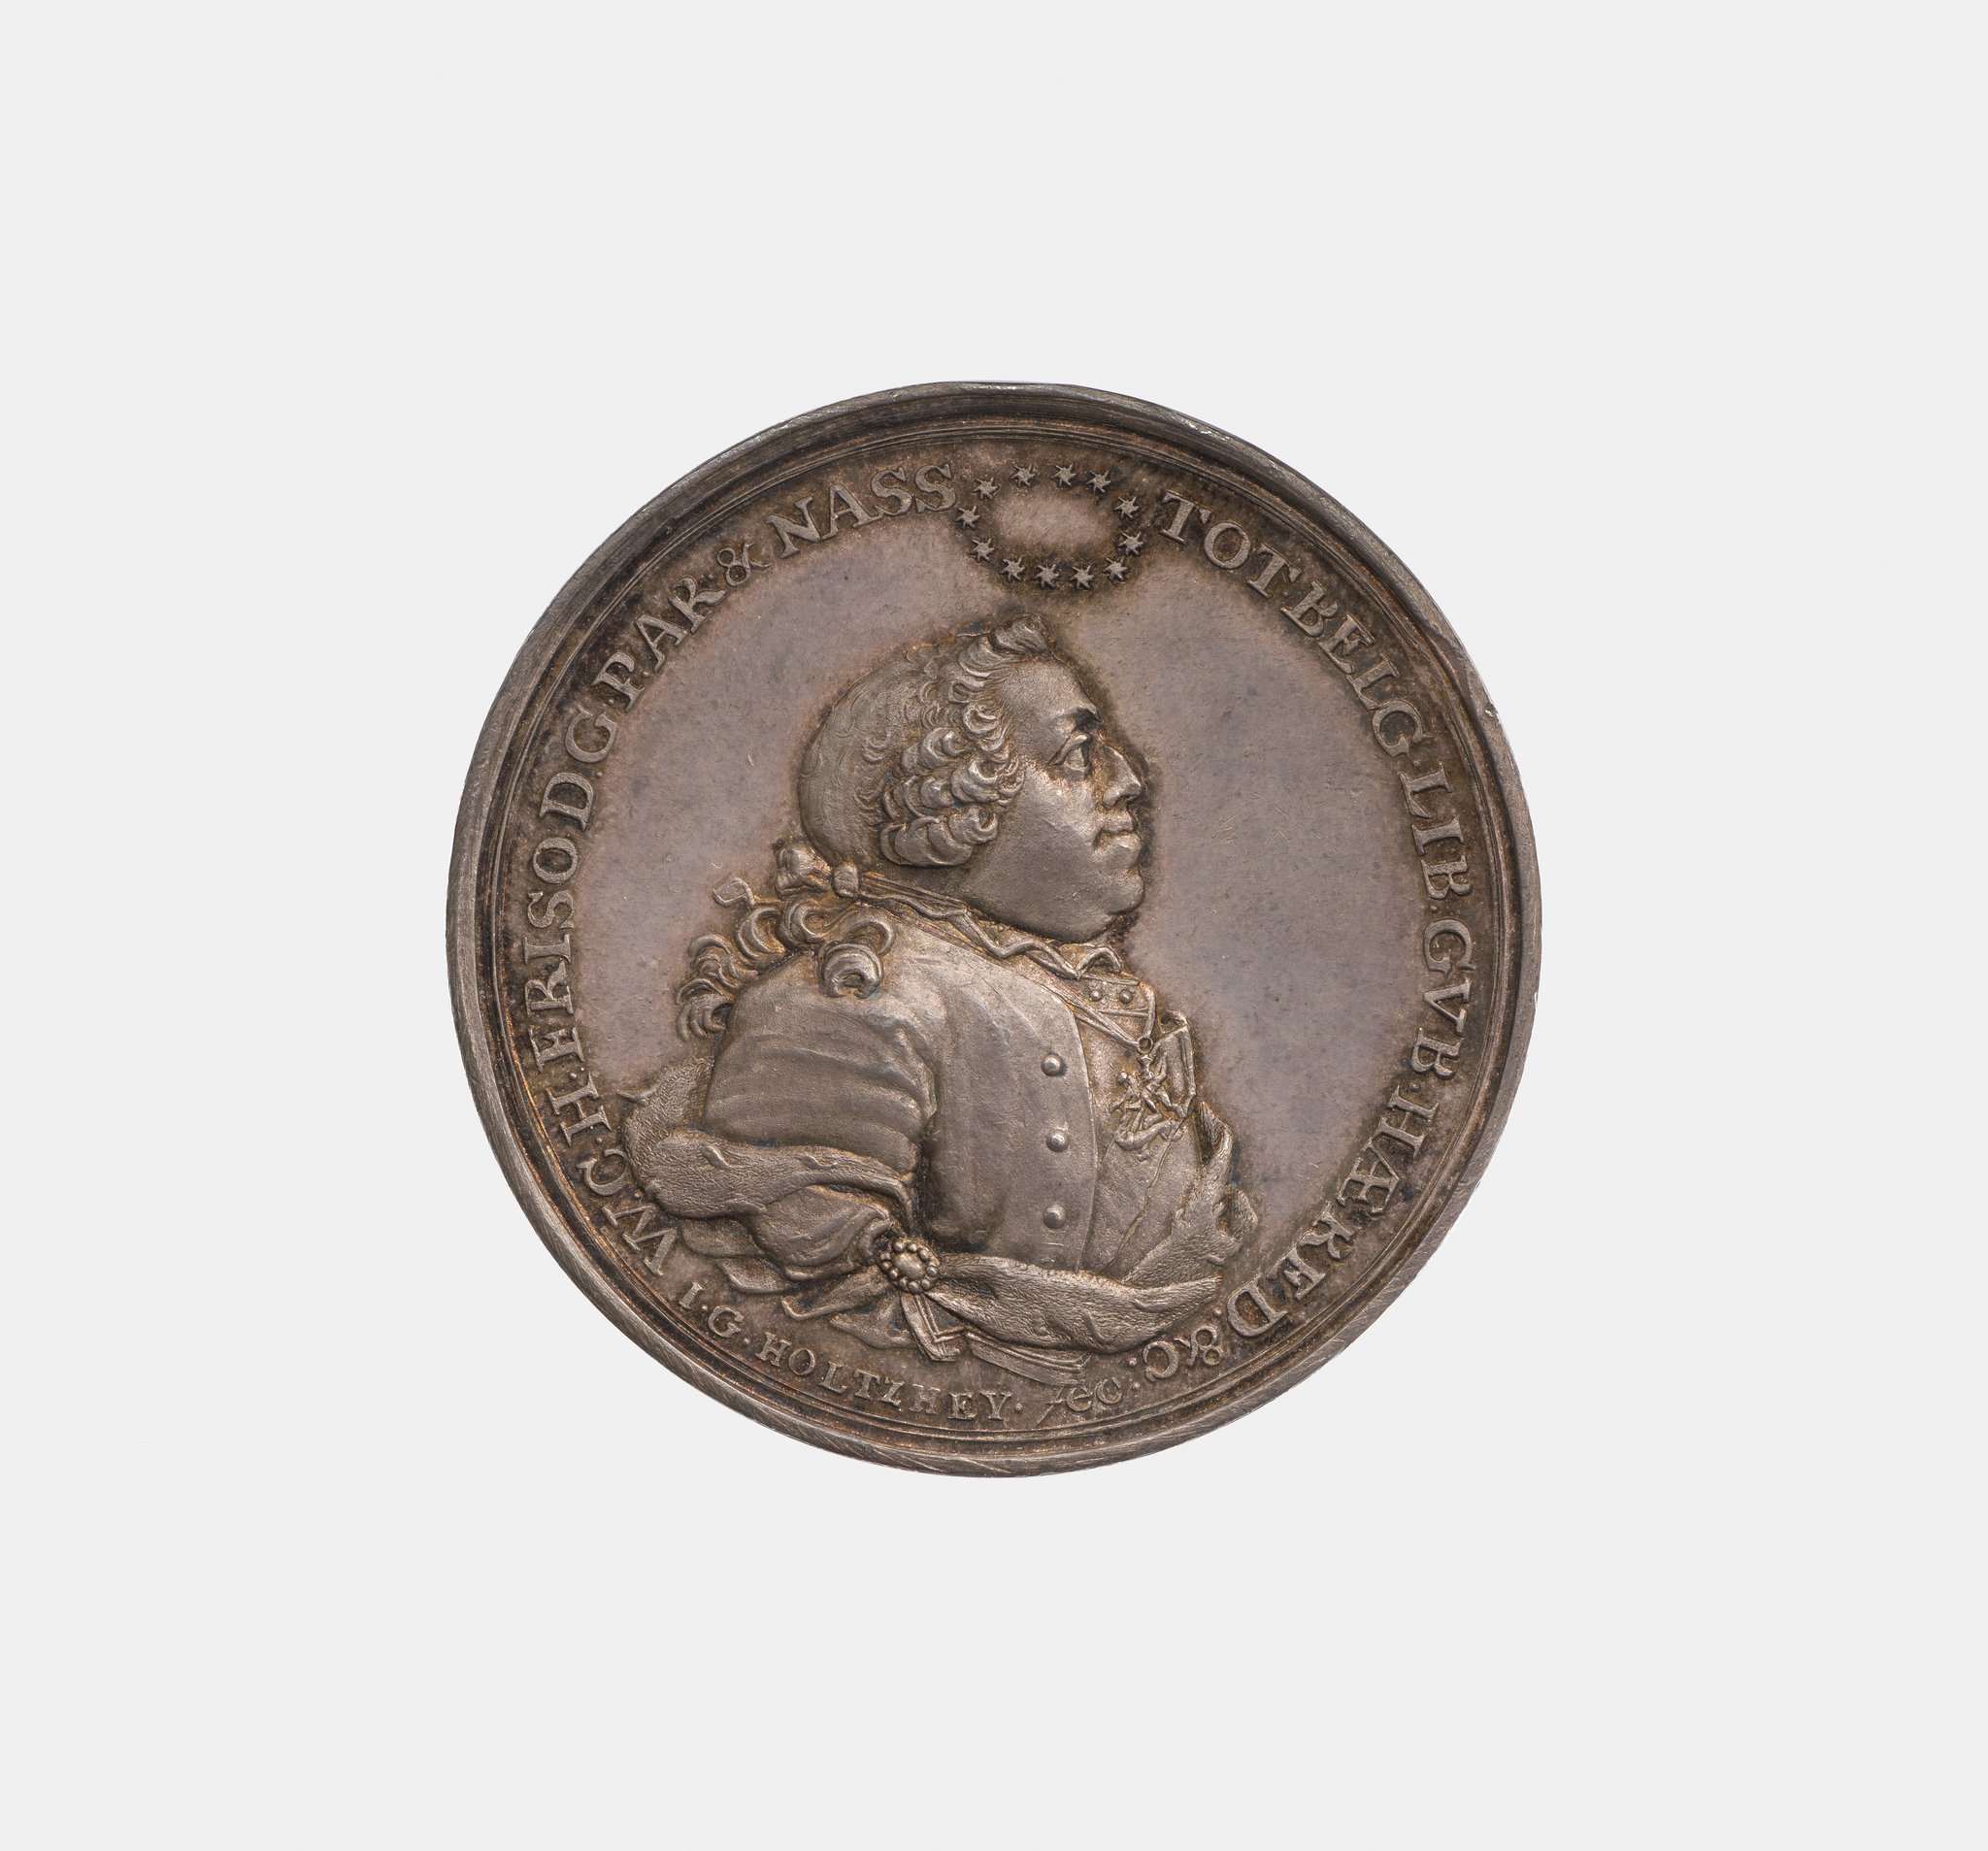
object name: medal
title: Death of Willem IV, Prince of Orange (1711–1751)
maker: johann georg holtzhey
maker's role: artist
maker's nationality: dutch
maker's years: 1729-1808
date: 1751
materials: silver